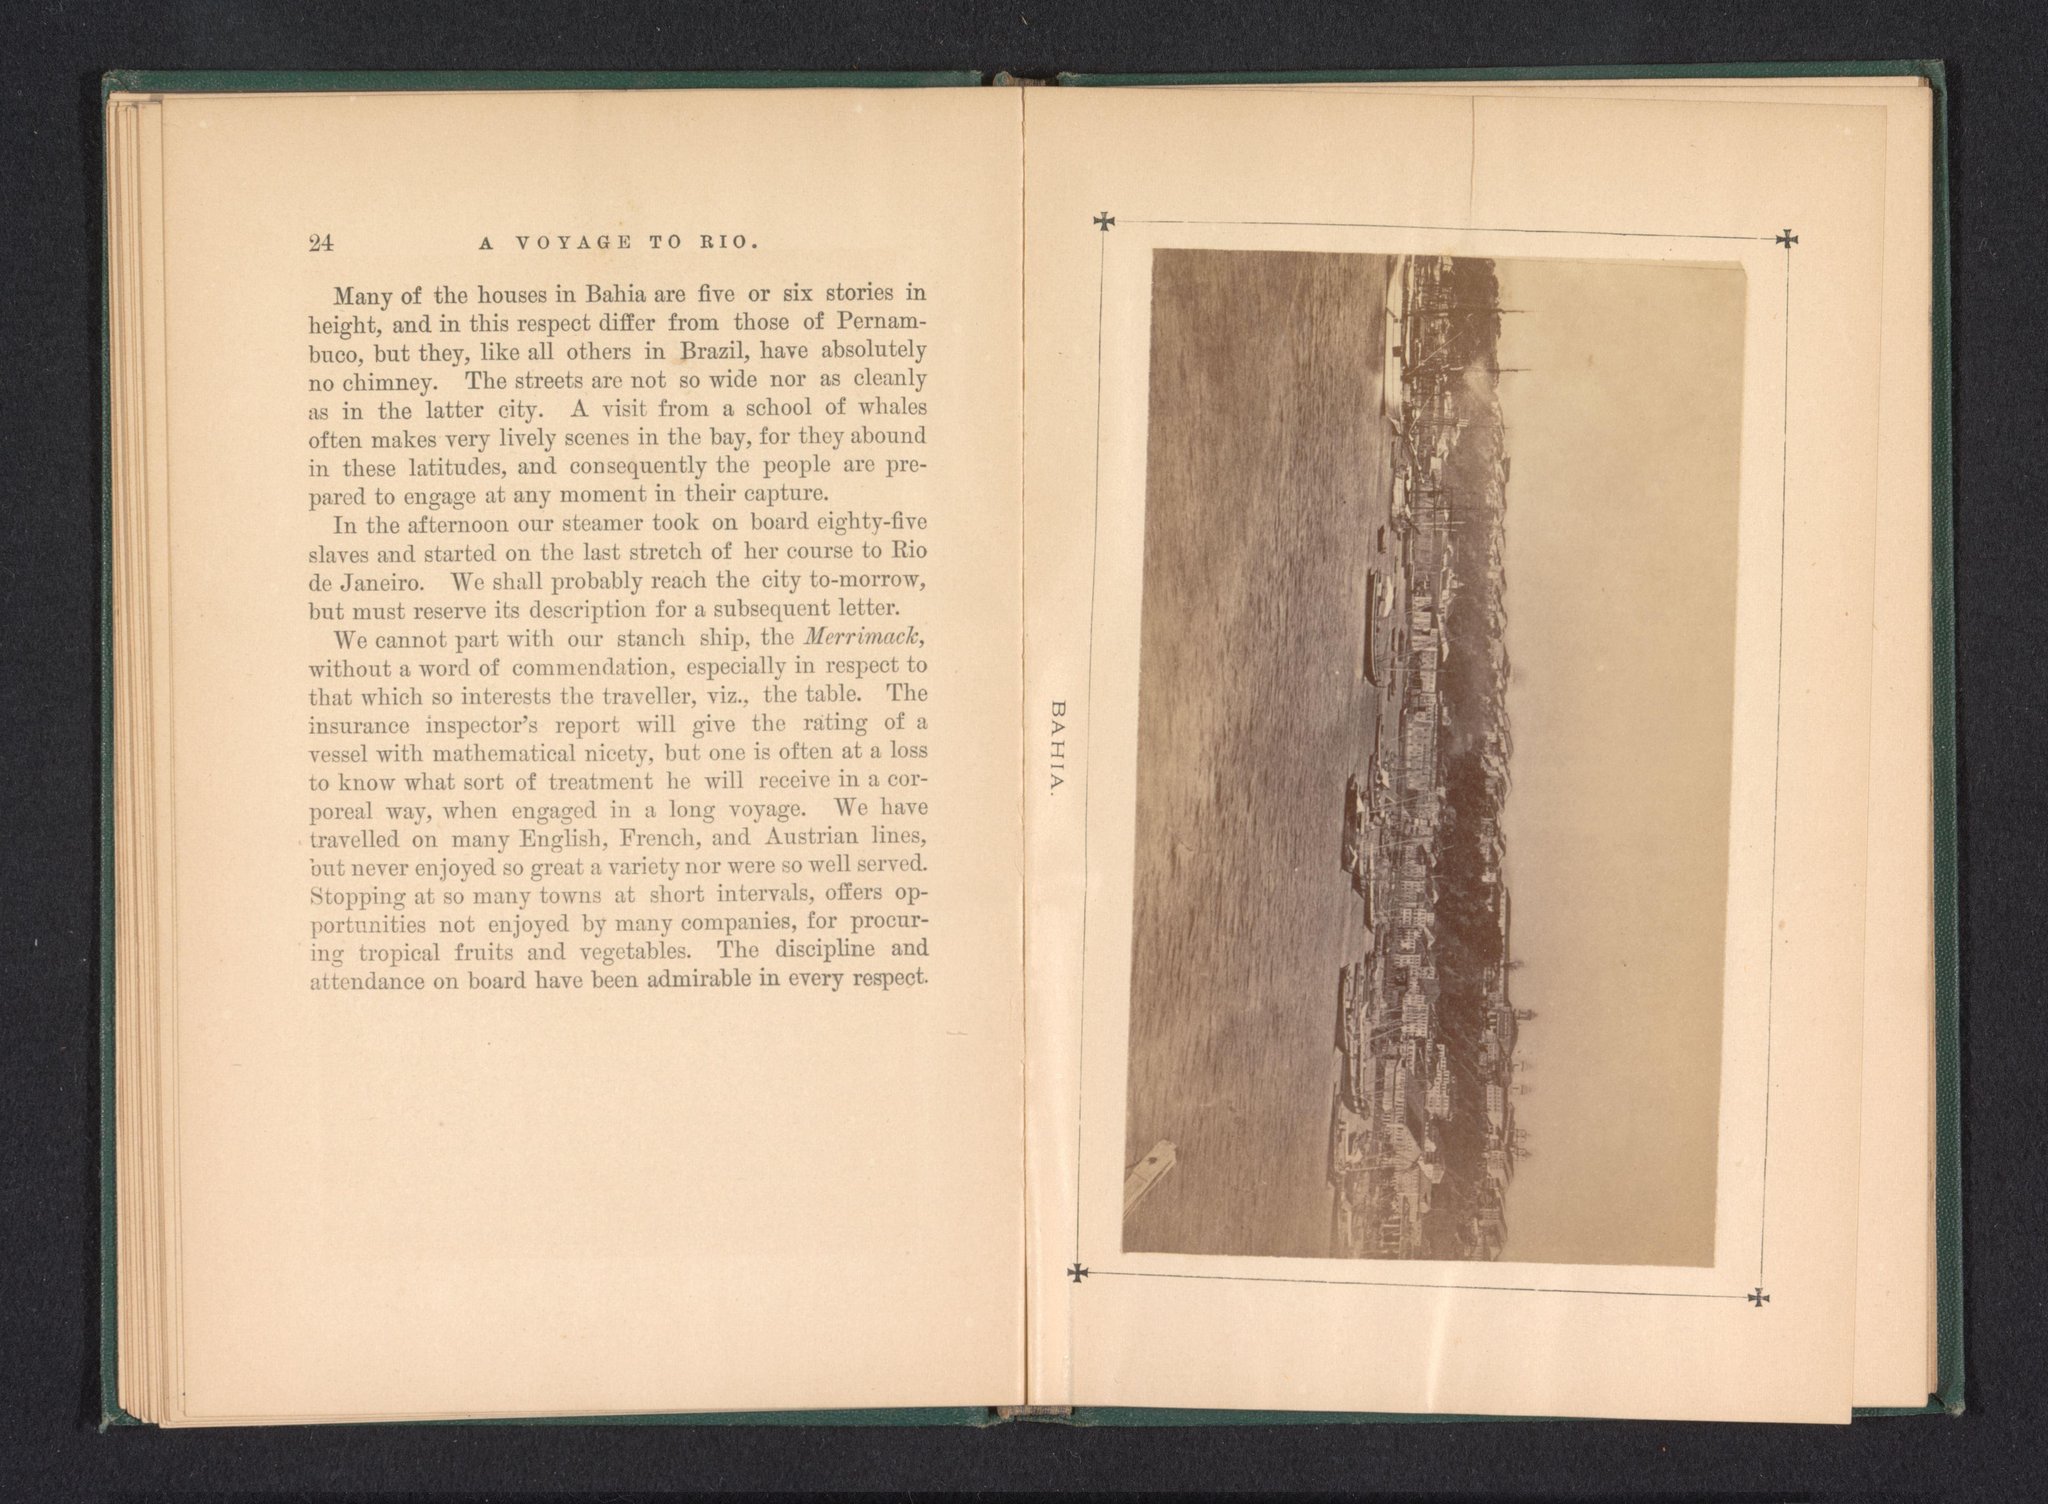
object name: photograph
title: Gezicht op een haven in de staat Bahia in Brazilië, vermoedelijk van Salvador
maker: Anonymous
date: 1864-1874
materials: photographic support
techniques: albumen print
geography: bahia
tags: harbour